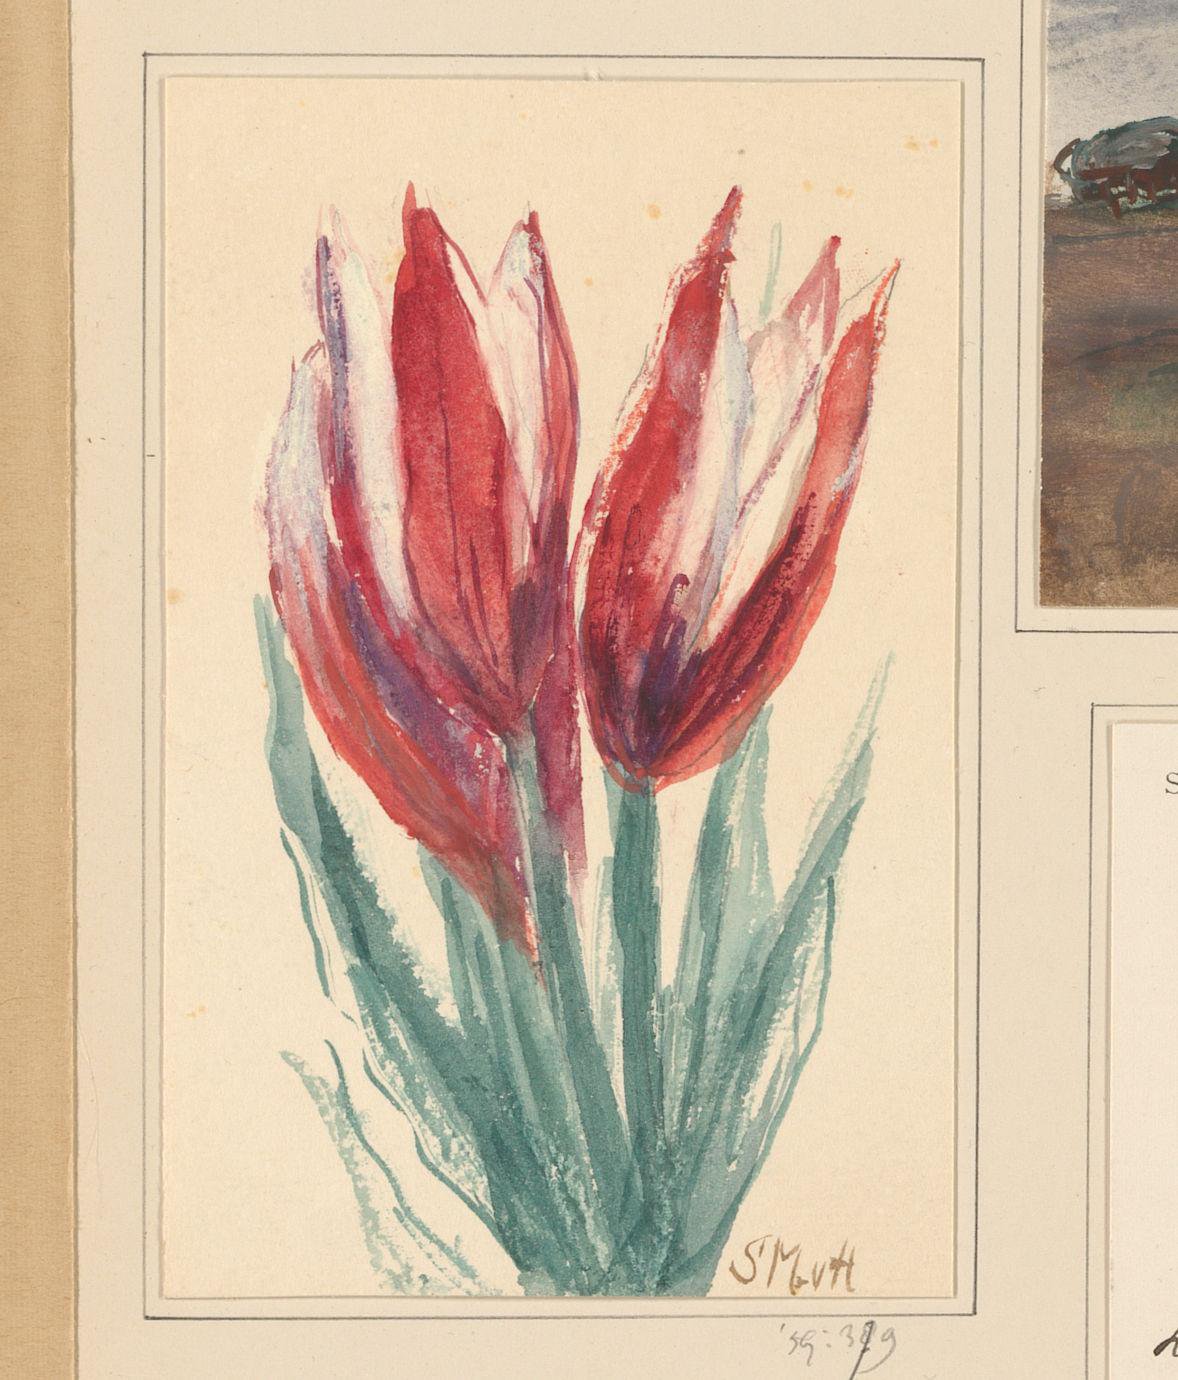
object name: drawing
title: Tulpen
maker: sientje mesdag-van houten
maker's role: draughtsman, painter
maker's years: 1834-1909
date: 1856-1909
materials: paper, pencil, watercolor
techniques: brush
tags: flowers: tulip